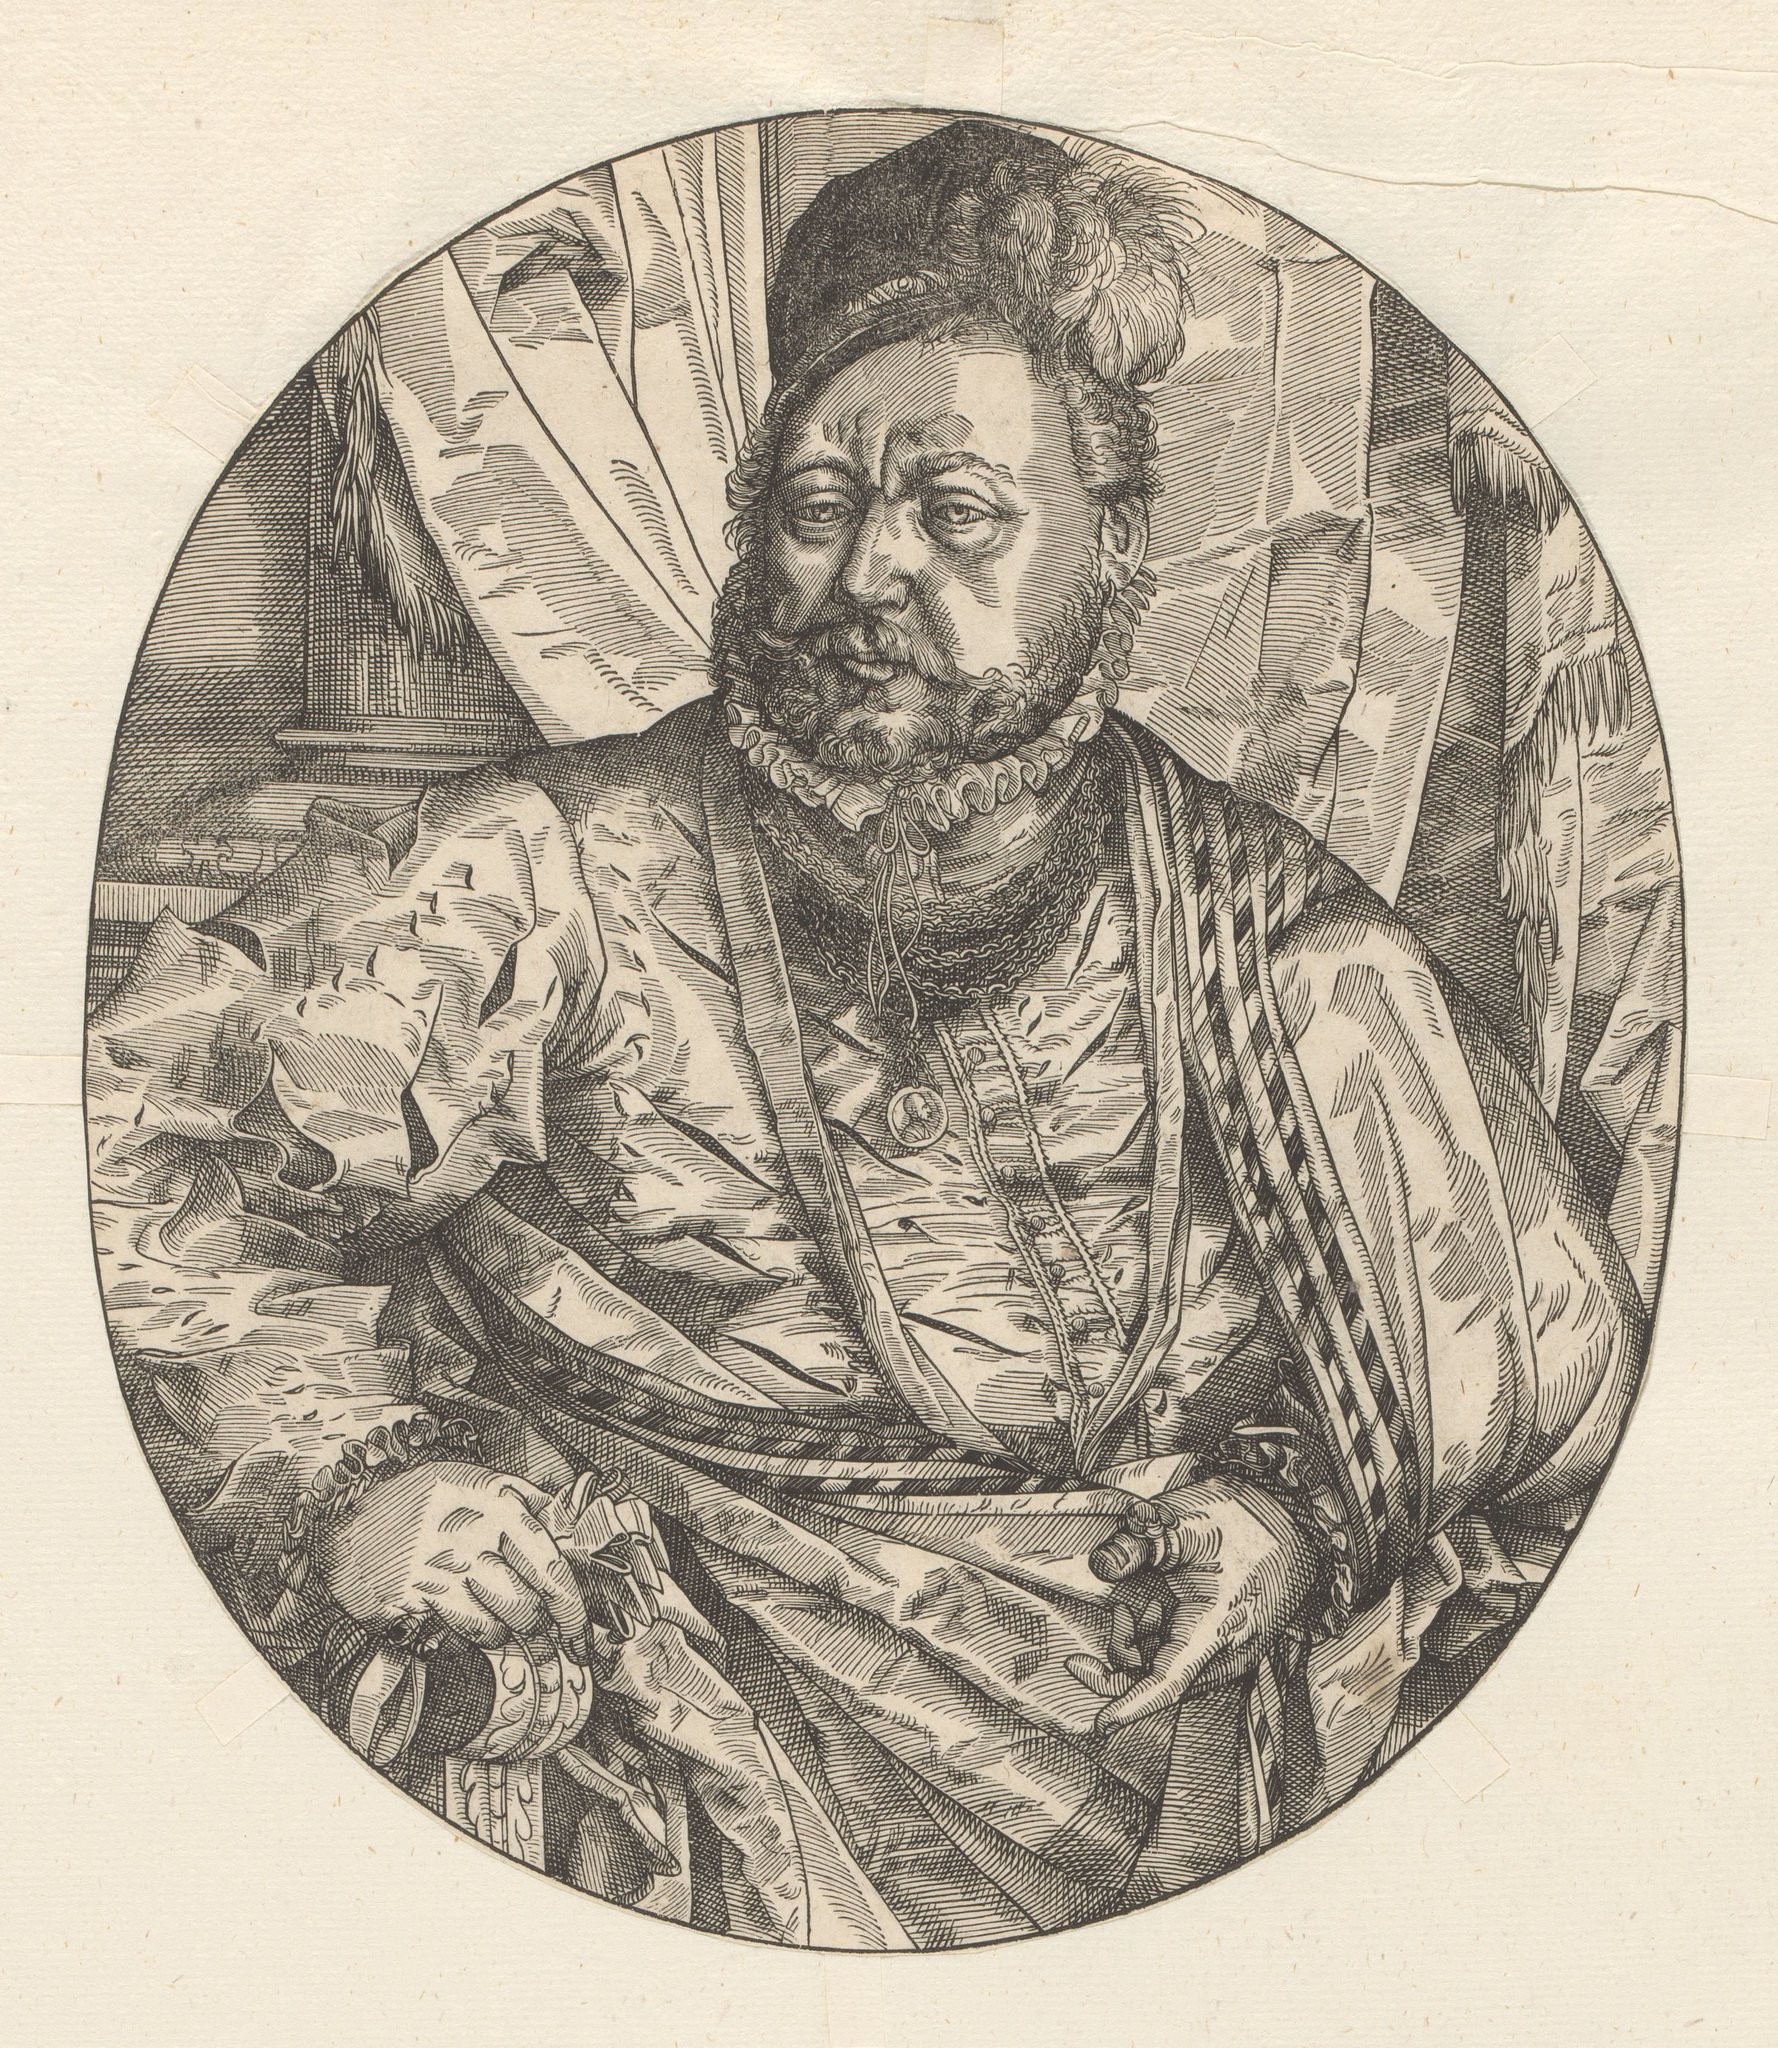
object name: book illustration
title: Portret van Otto Heinrich von Schwarzenberg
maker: Anonymous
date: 1549-1584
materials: paper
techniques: woodcut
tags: politician, otto heinrich von schwarzenberg, historical persons, politician, e.g. party leader